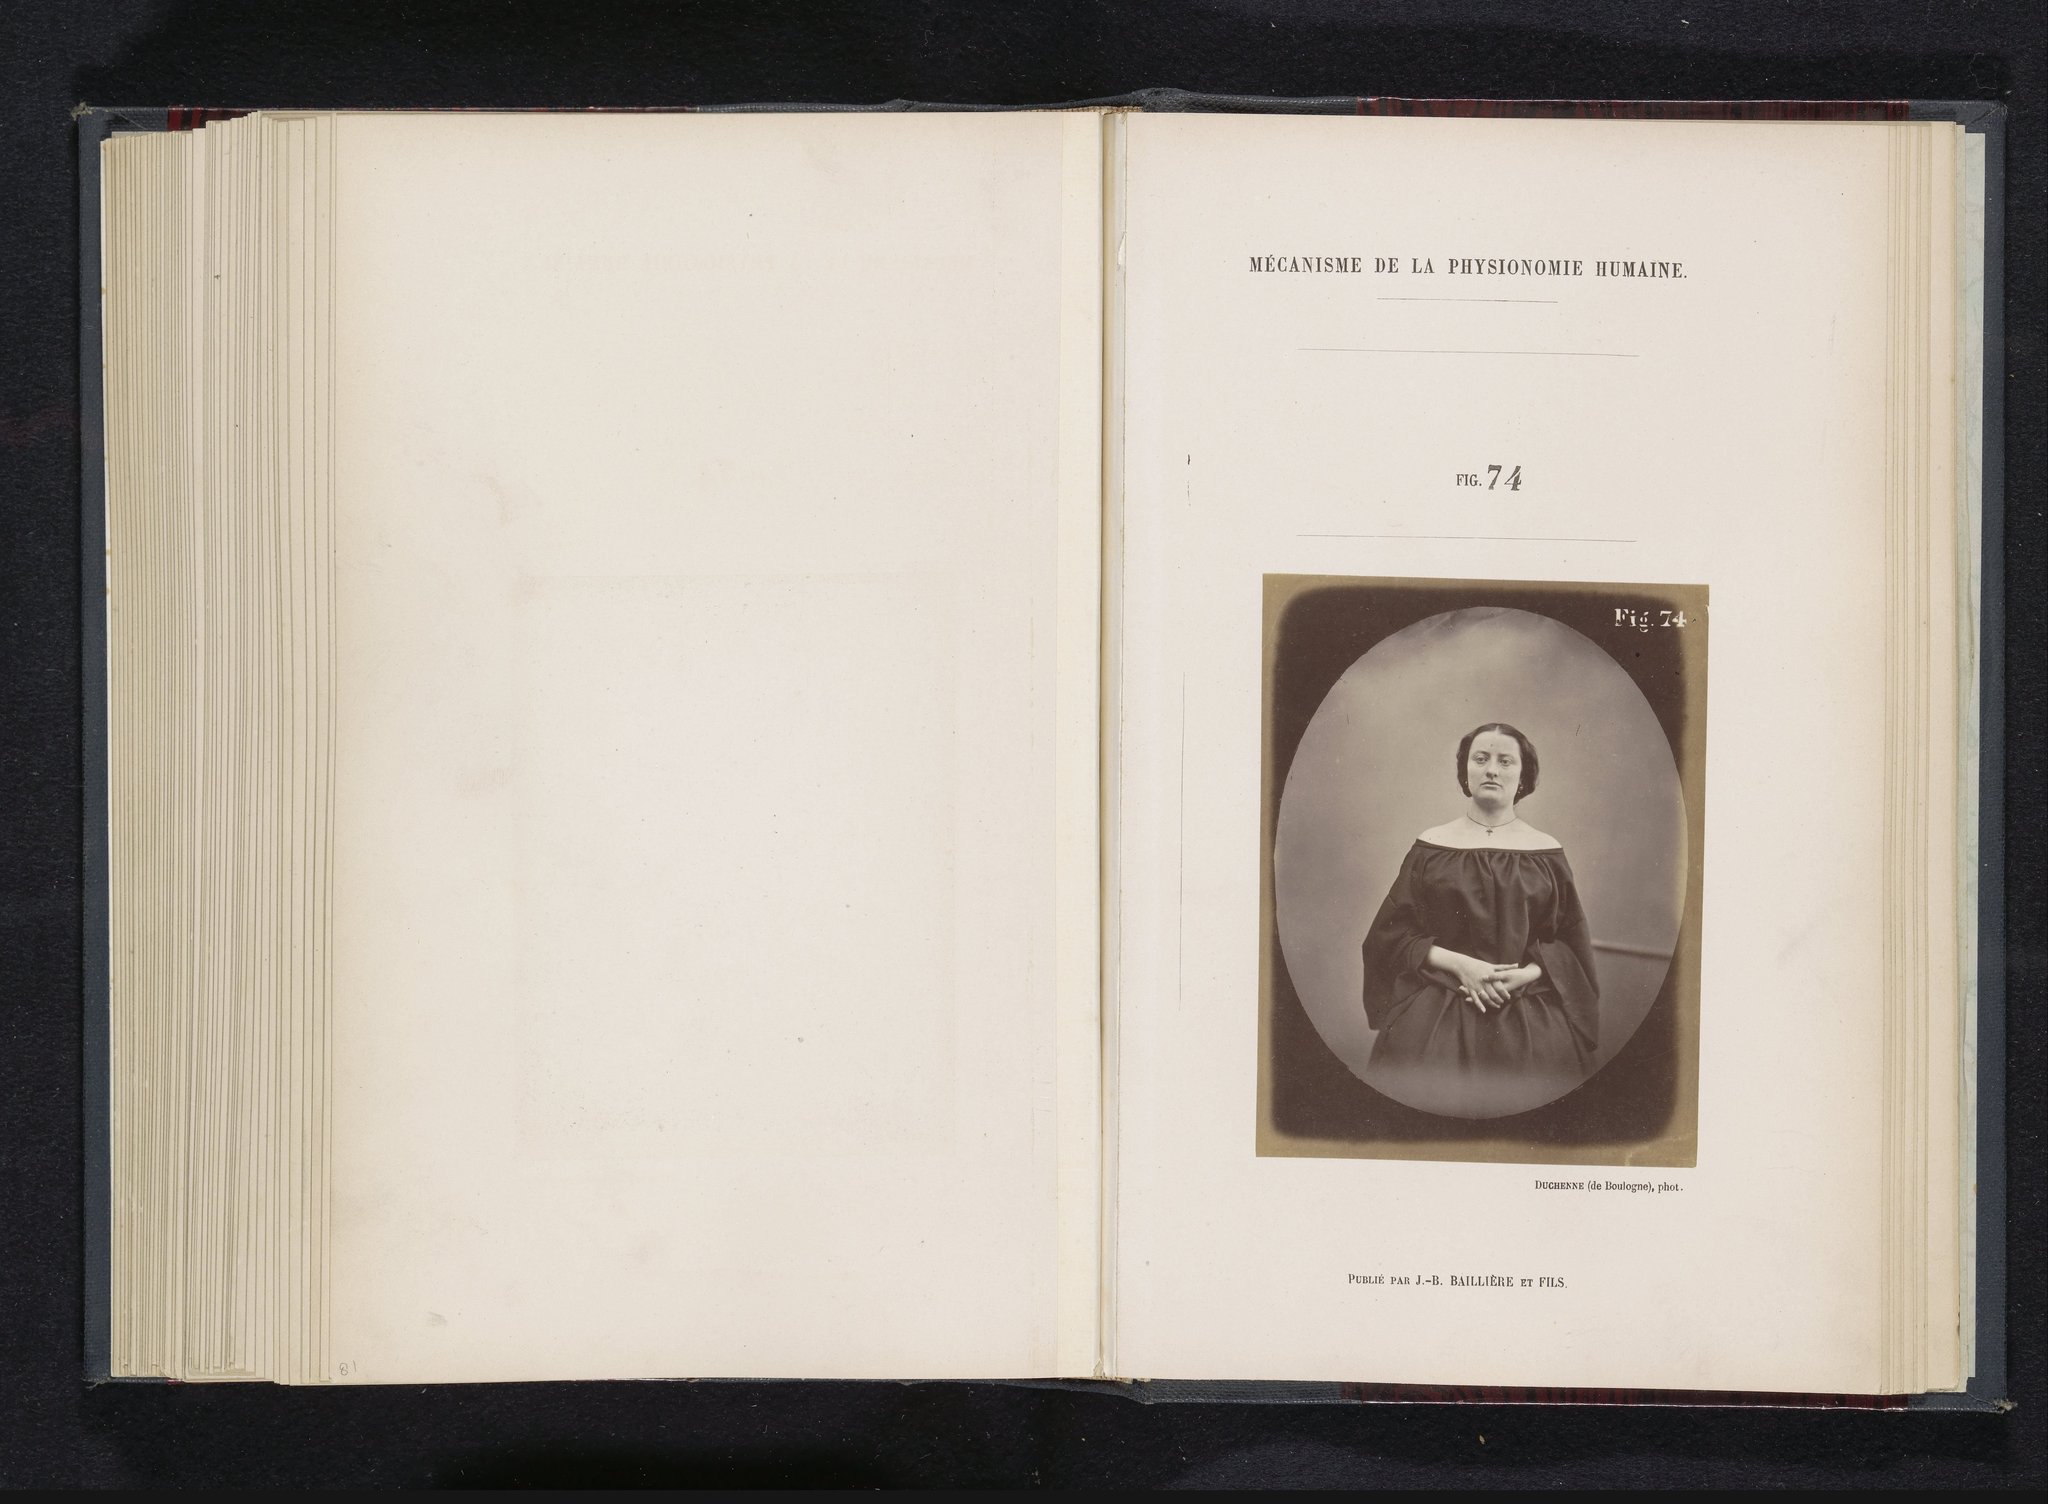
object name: photograph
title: Portret van een proefpersoon: 'la jeune fille'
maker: guillaume benjamin amand duchenne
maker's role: fotograaf, medicus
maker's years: 1806-1875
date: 1860-1862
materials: paper, photographic support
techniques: albumen print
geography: france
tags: face, adult woman, physiology and anatomy ~ nervous system, neurology, physiology and anatomy, morphology of facial expression, physiognomy, experiment, test ~ science and technology, france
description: Ongenummerde pagina met foto 74 uit Mécanisme de la physionomie humaine ou analyse électro-physiologique de l'expression des passions (Atlas).